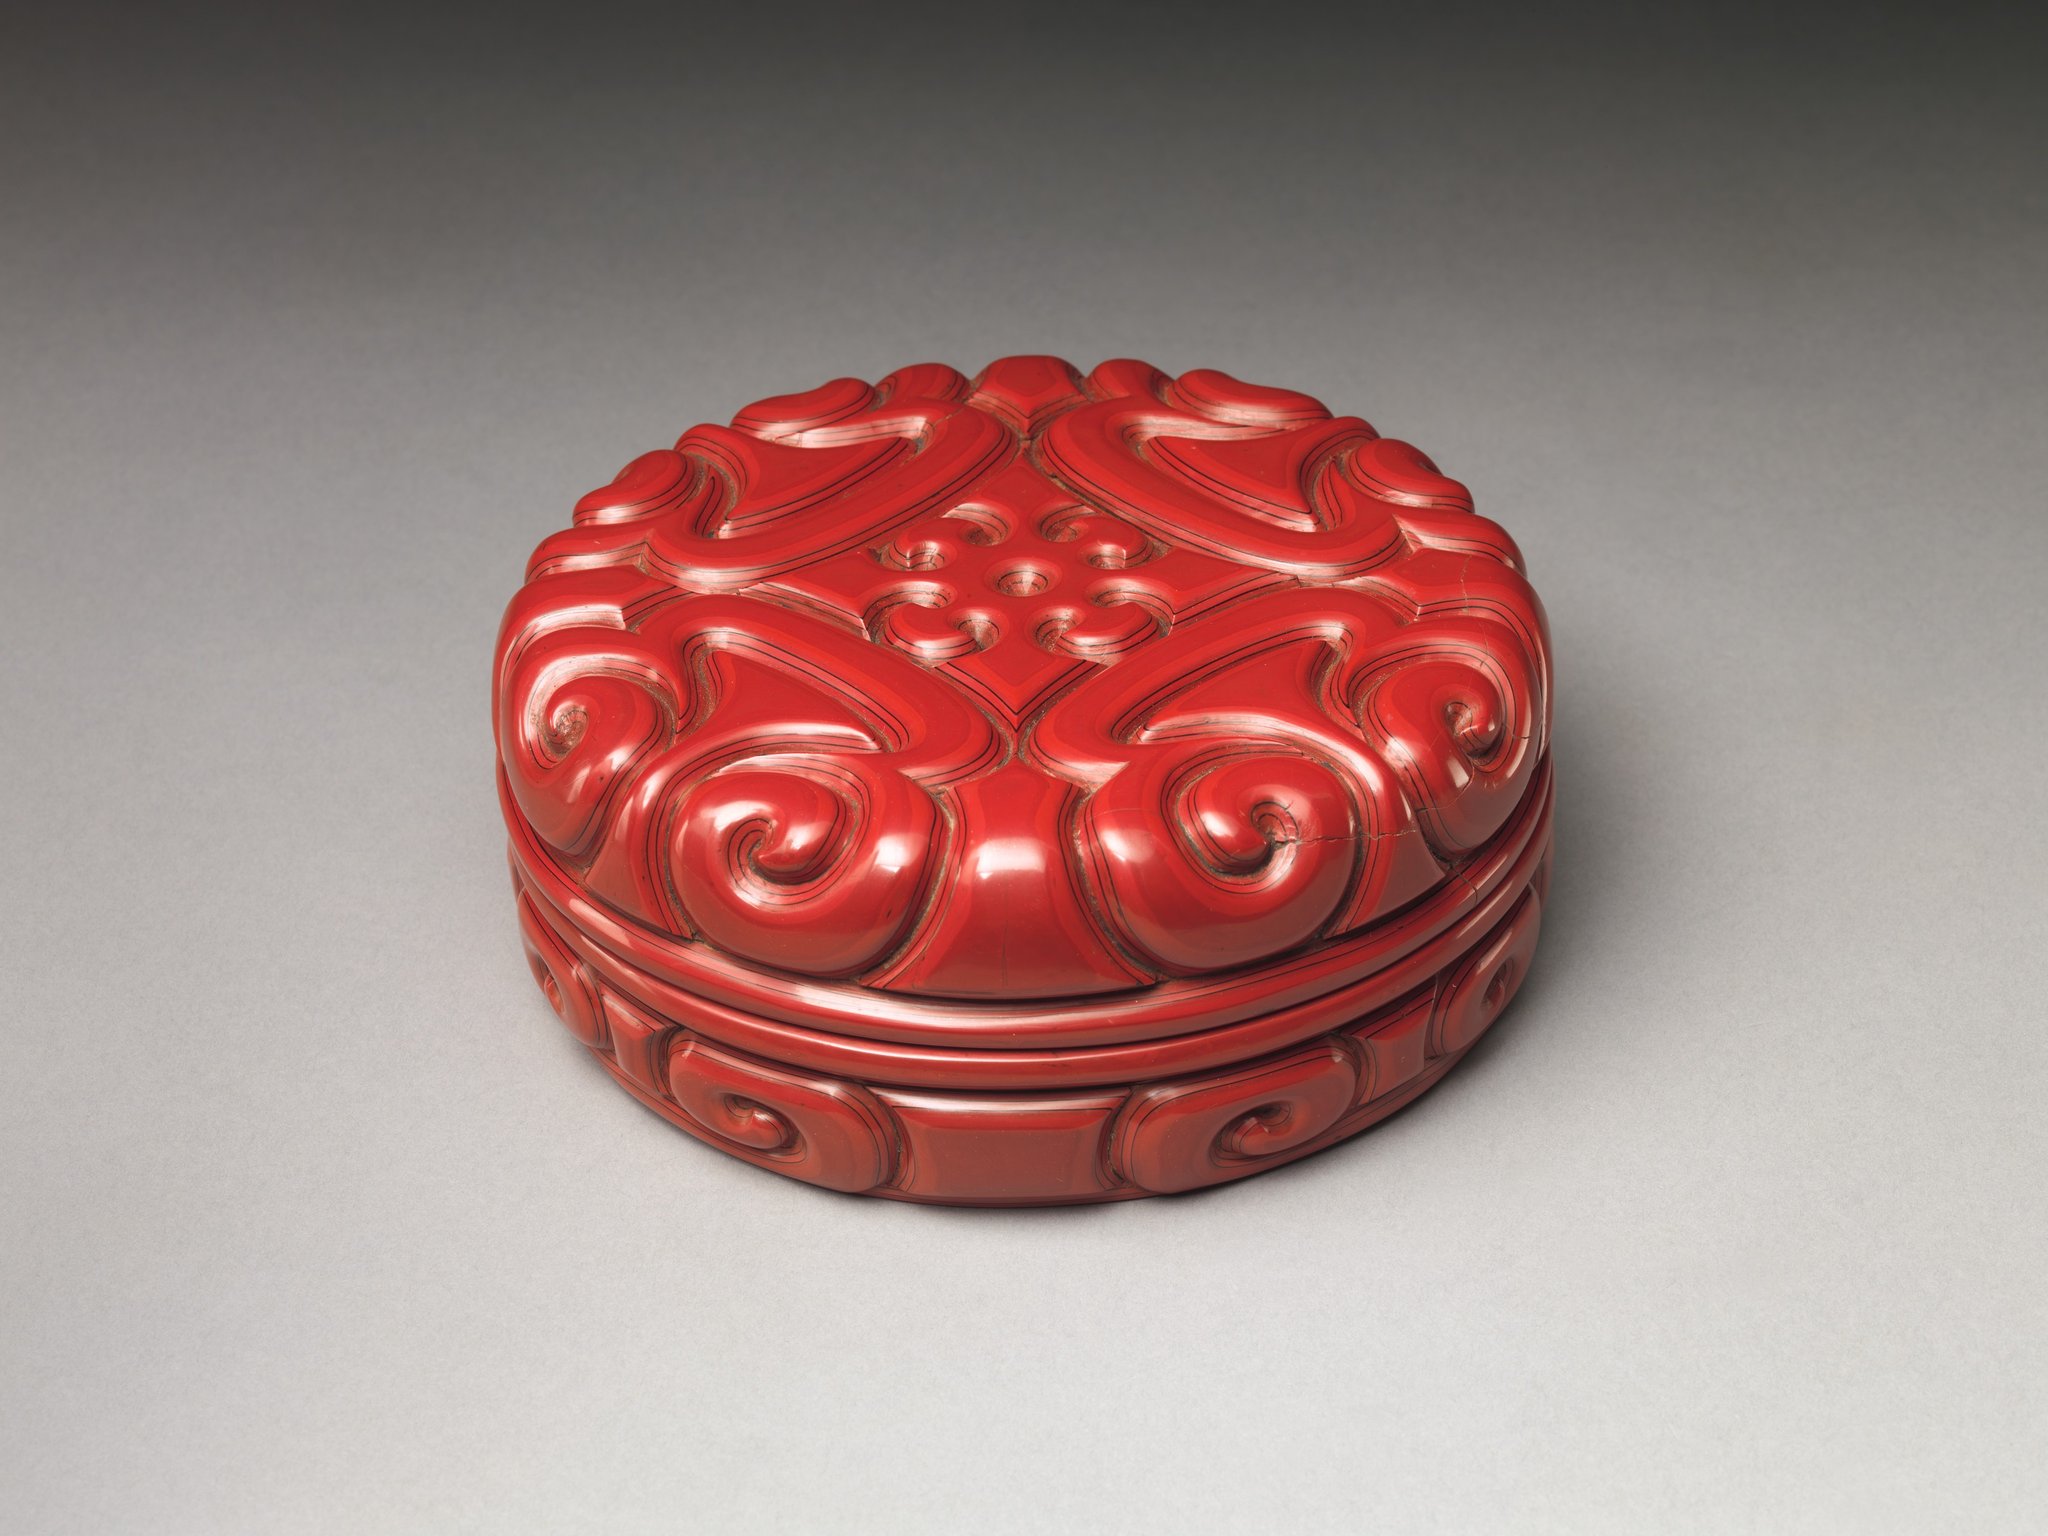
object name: box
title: Box with Pommel Scroll Design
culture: chinese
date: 1301-1400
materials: lacquer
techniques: carving